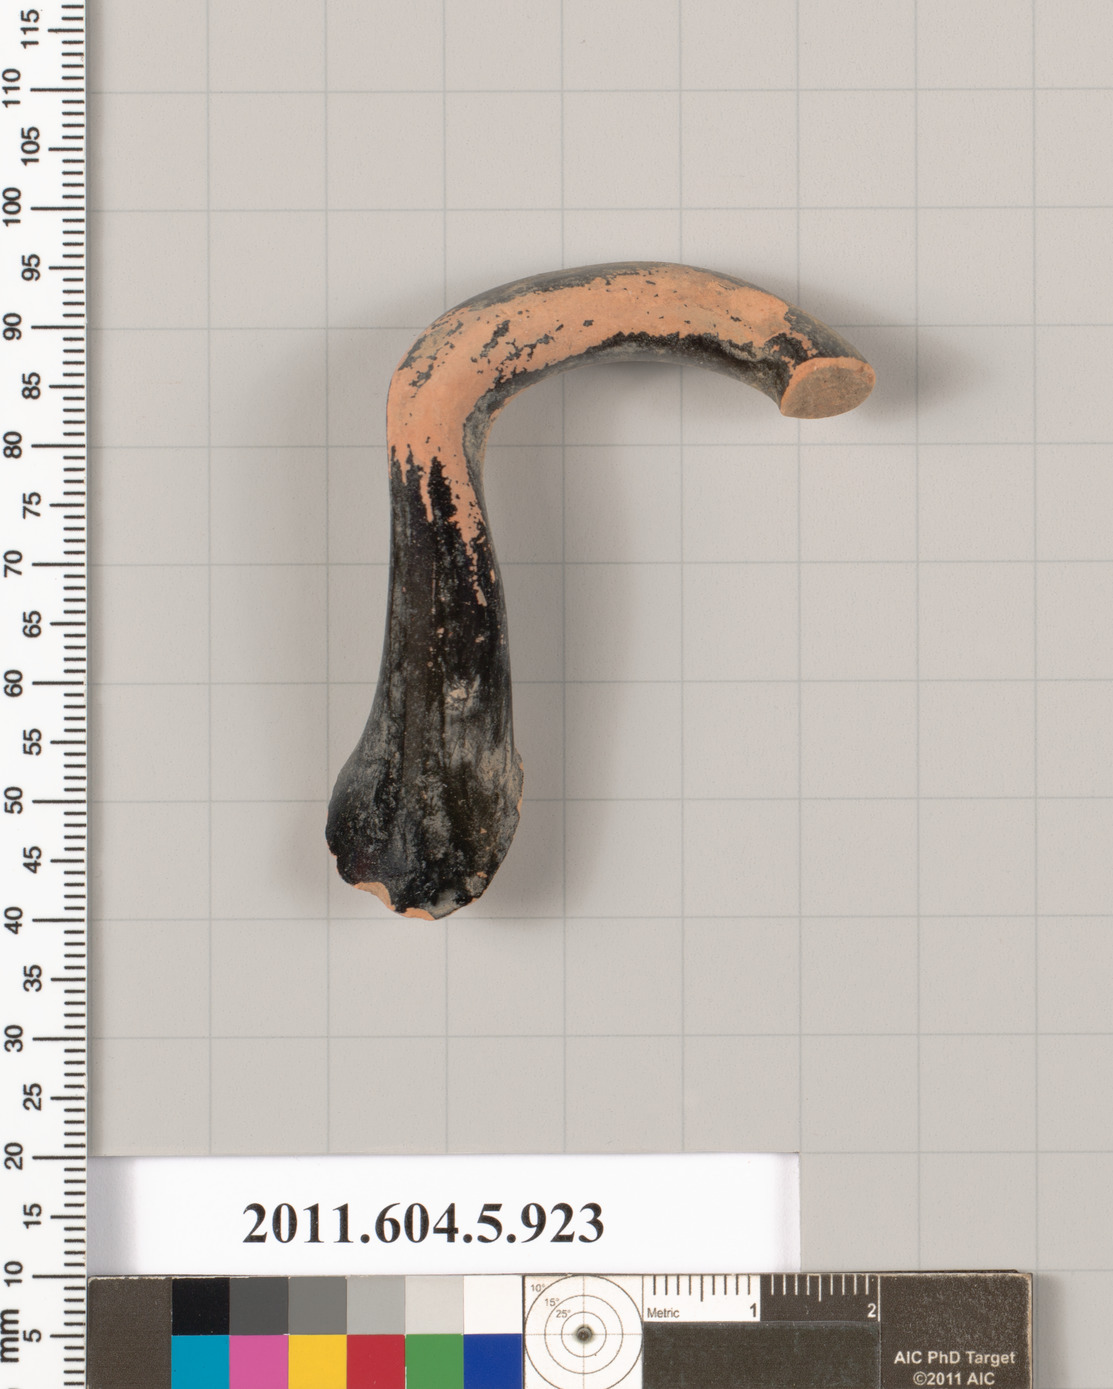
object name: kylix fragment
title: Terracotta fragment of a kylix (drinking cup)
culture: greek, attic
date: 600-401 BCE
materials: terracotta